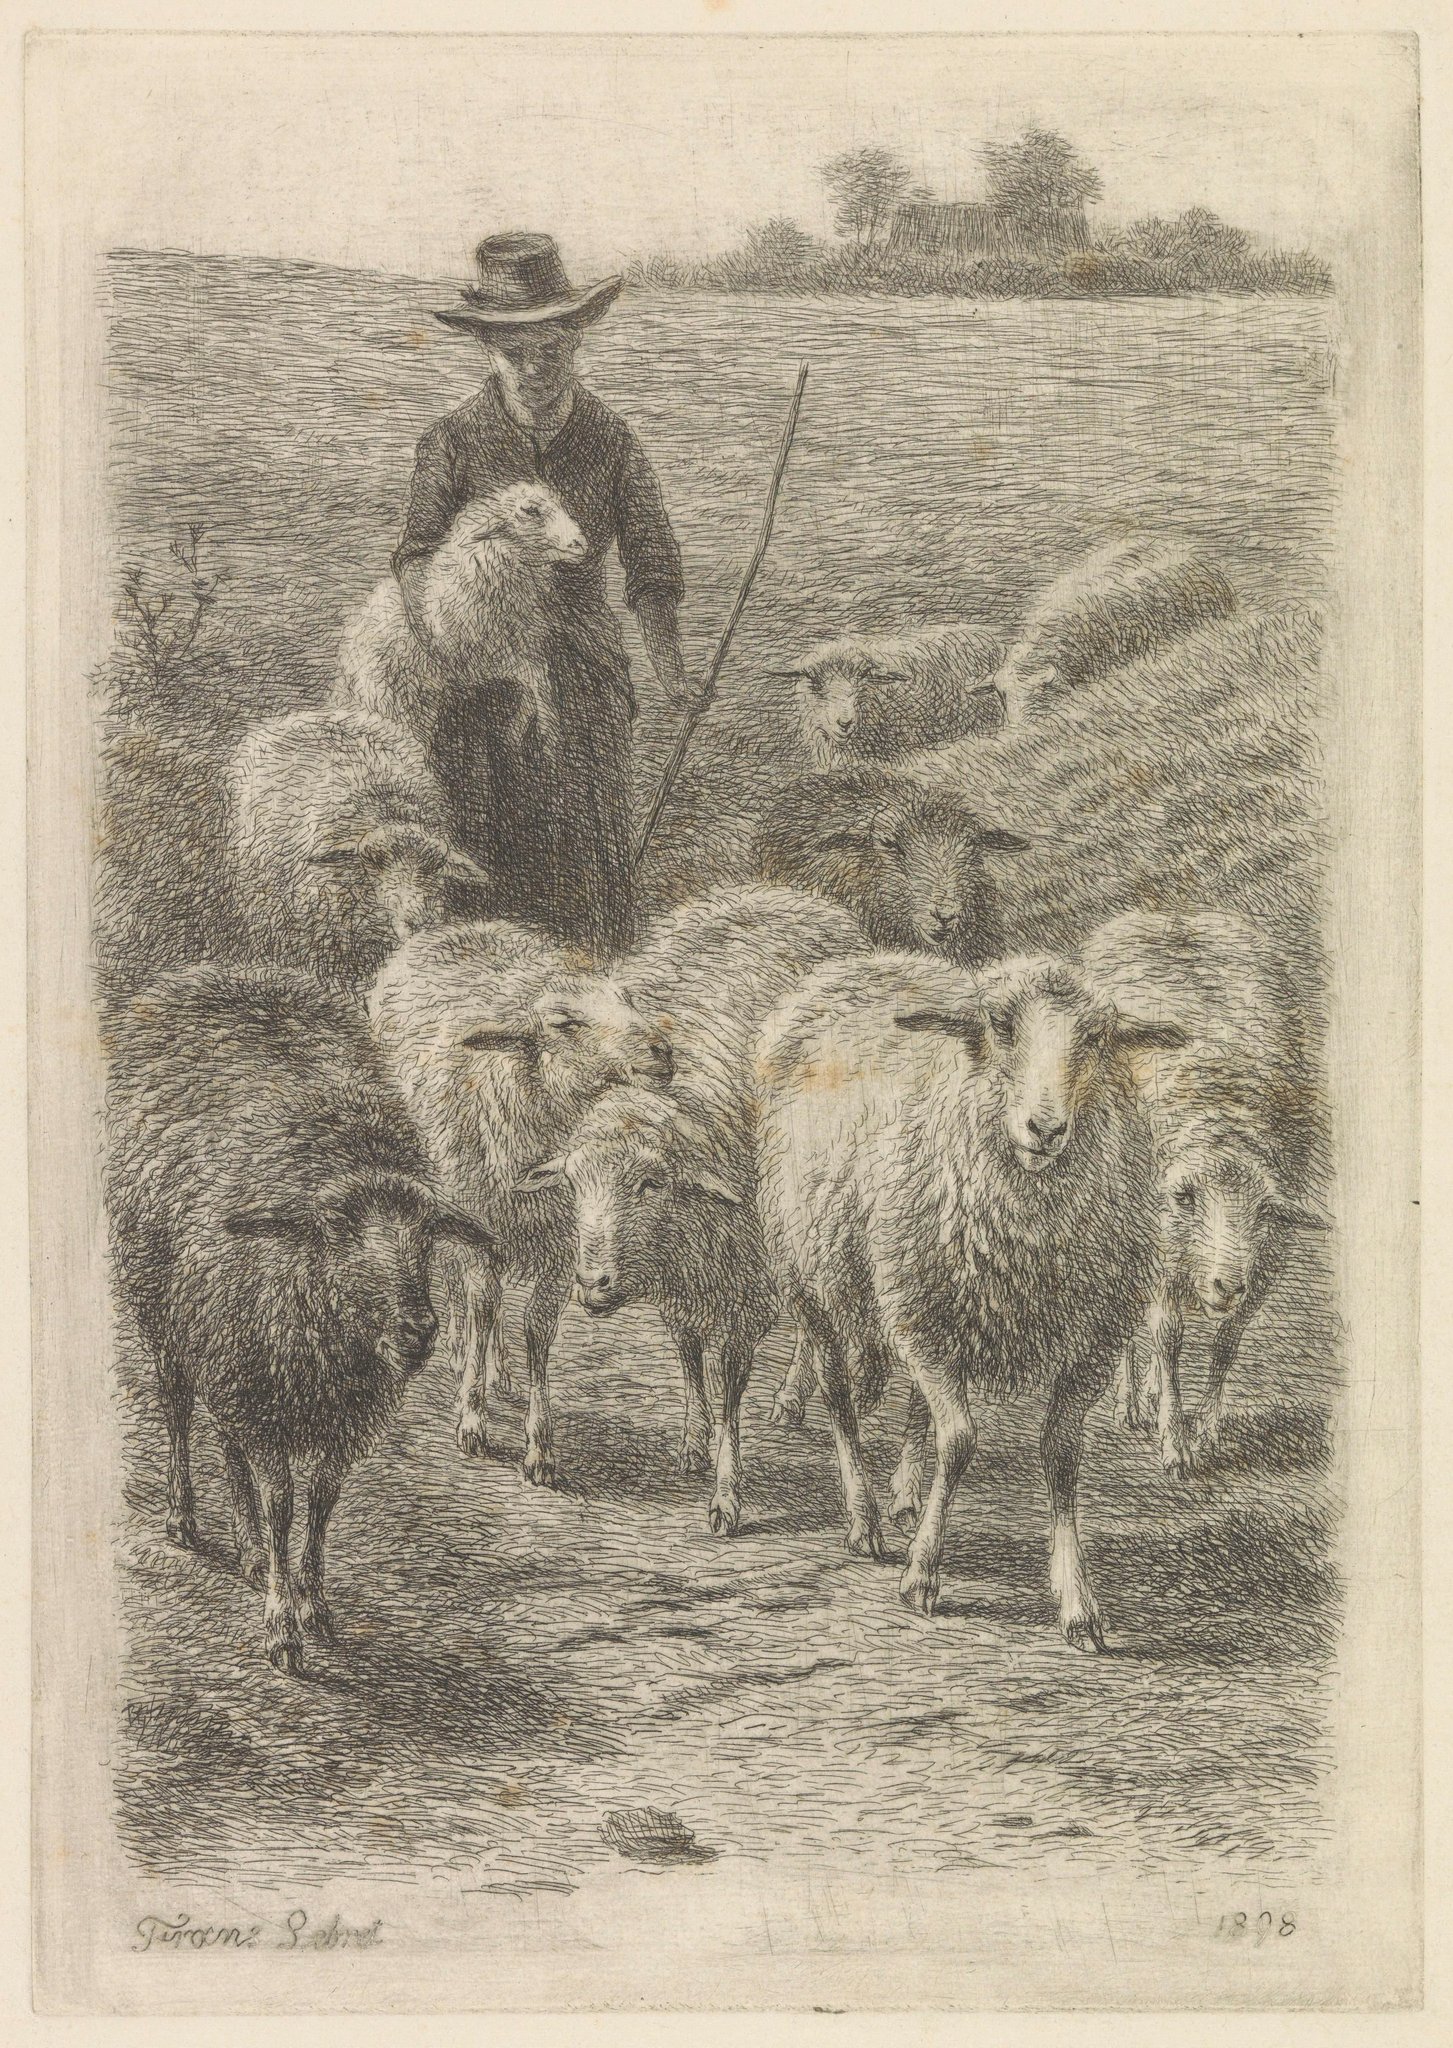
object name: print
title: Schaapherder met zijn kudde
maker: frans lebret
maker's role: draughtsman, painter, print maker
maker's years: 1820-1909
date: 1898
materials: paper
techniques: etching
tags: herding, herdsman, herdswoman, shepherd, shepherdess, cowherd, etc., sheep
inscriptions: collector's mark: Lugt 2228, number: ‘13’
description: Een schaapherder loopt te midden van zijn kudde schapen. Hij heeft een schaap onder de arm genomen.